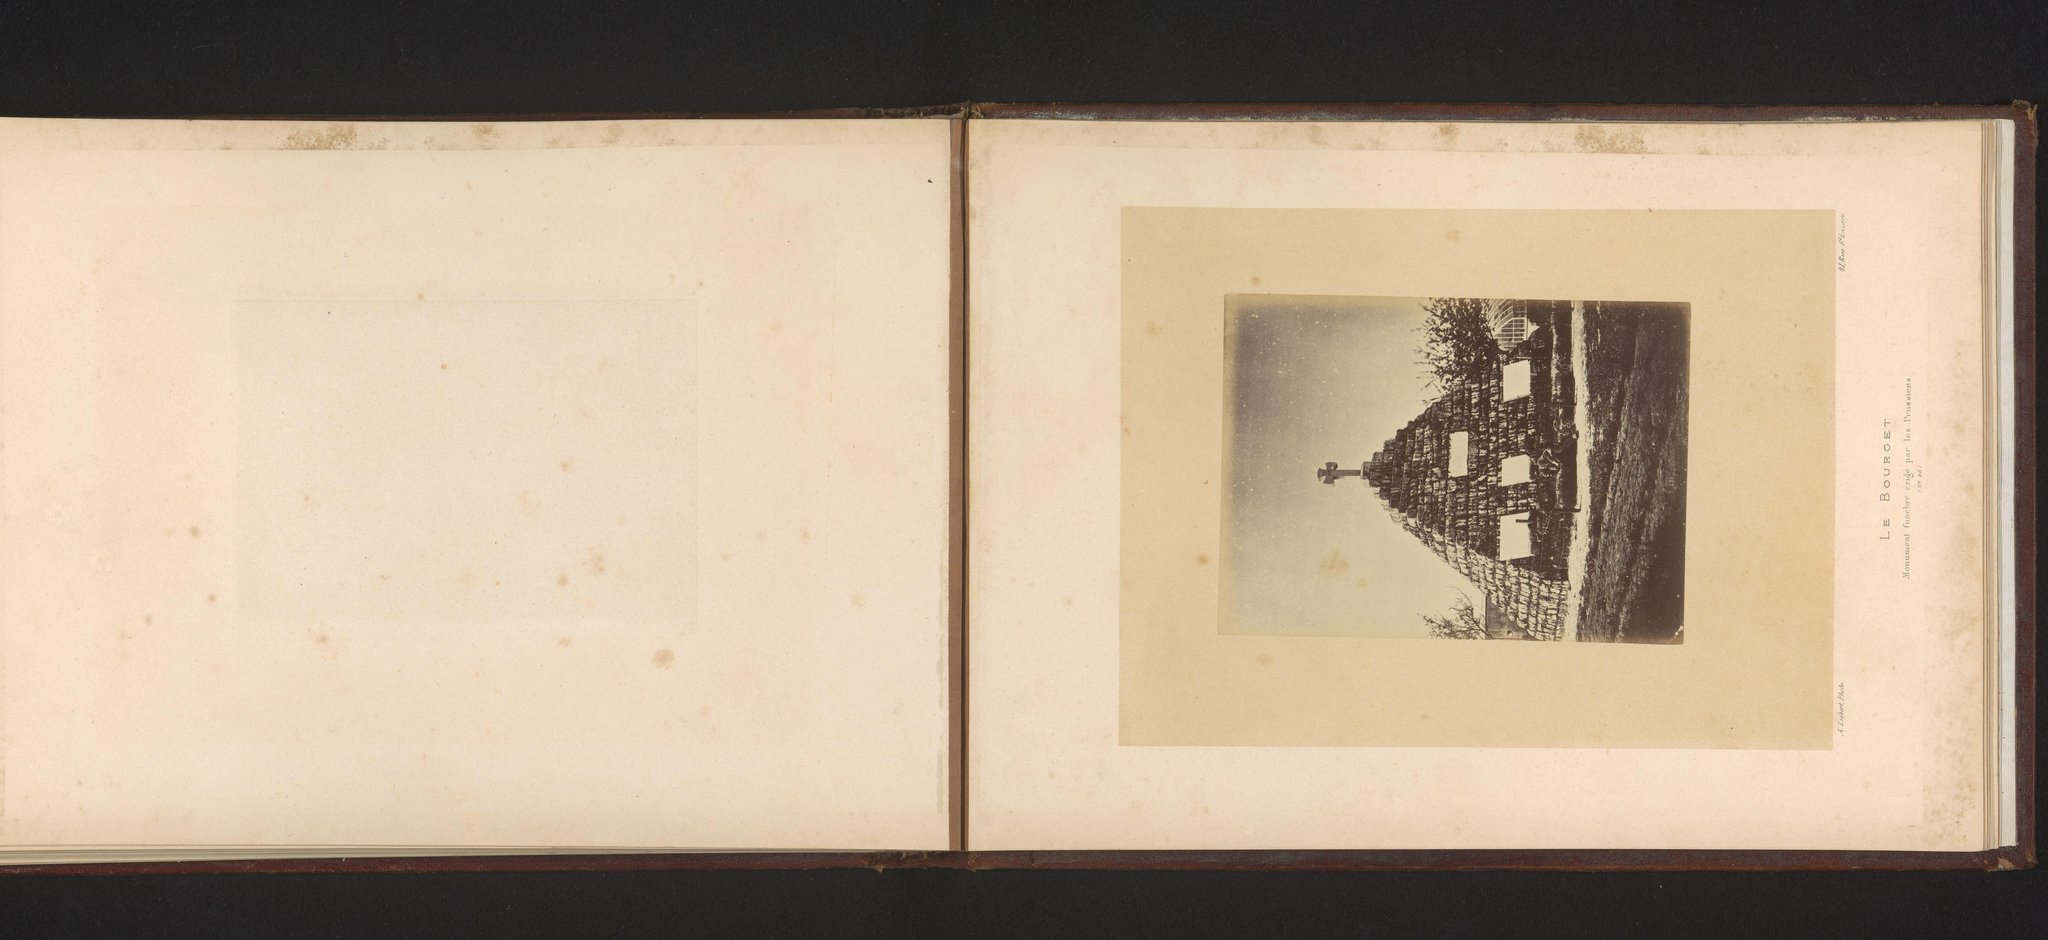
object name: page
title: Le Bourget. Monument funèbre erigé par les Prussiens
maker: alphonse-justin liébert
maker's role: fotograaf, marinier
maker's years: 1827-1914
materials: photographic support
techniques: albumen print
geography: le bourget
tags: grave, tomb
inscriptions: address: ‘31, Rue St. Lazare’, number: ‘(No. 96)’